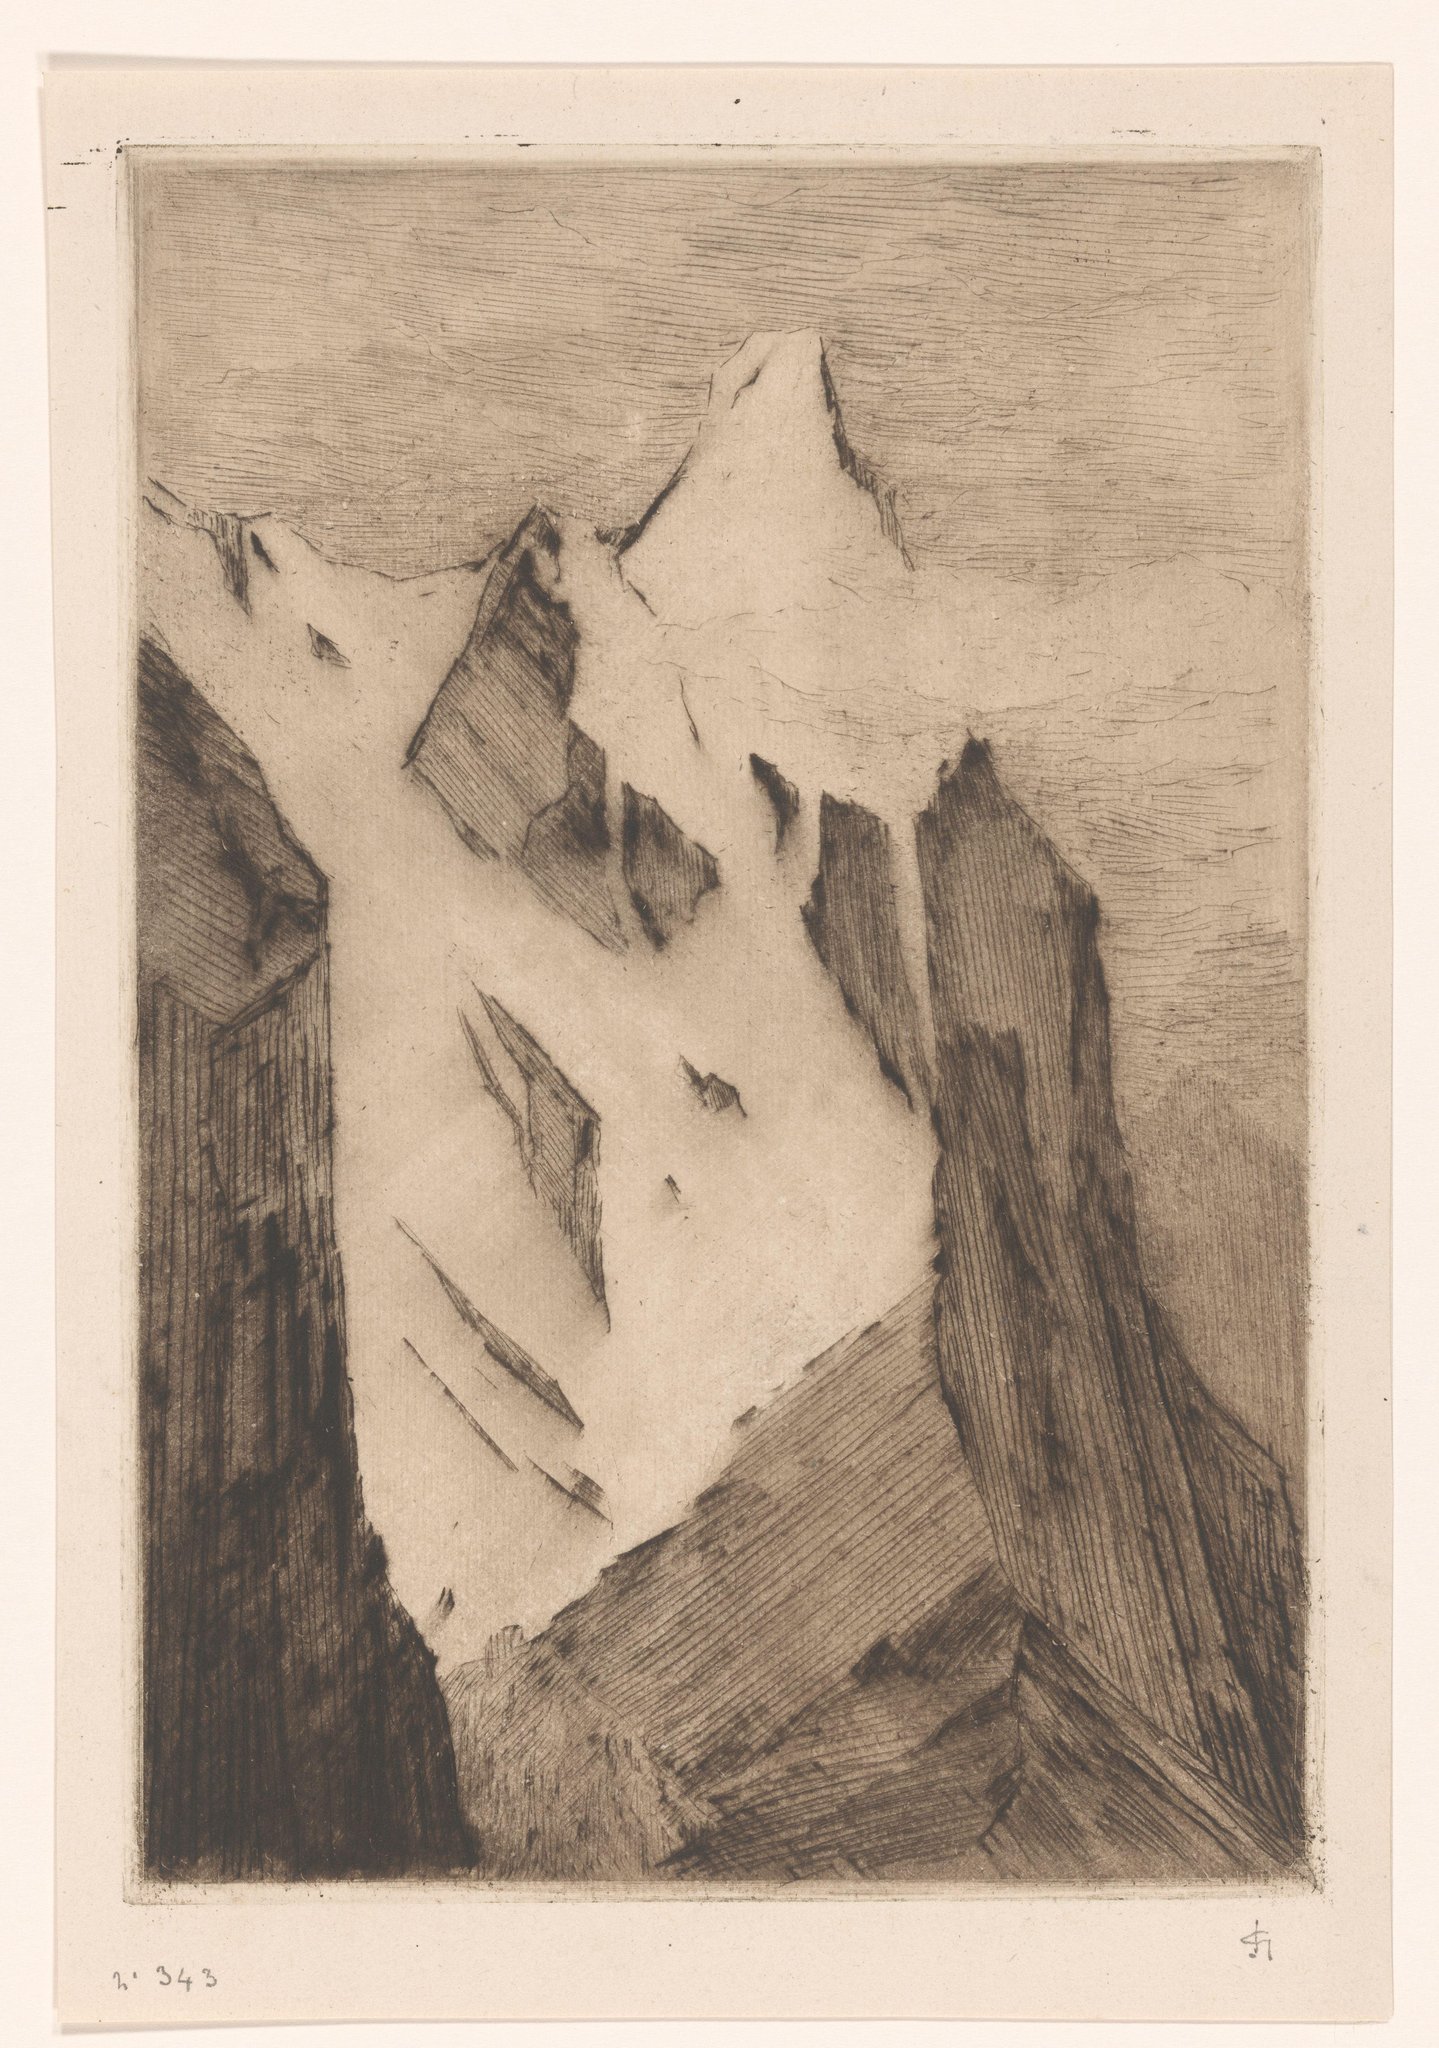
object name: print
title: Met sneeuw bedekte bergtop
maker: carel nicolaas storm van s-gravesande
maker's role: draughtsman, print maker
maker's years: 1841-1924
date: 1851-1902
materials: paper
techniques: drypoint, etching, intaglio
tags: mountain-range, snow peaks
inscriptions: number: ‘343’, collector's mark: Lugt 2228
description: Mogelijk vermeld in: Storm van 's-Gravesande, Charles. Catalogue des eaux-fortes et lithographies. New York: s.n., 1903, of in een onbekende latere uitgave van het manuscript. Vermoedelijk vermeld als catalogusnummer 343.